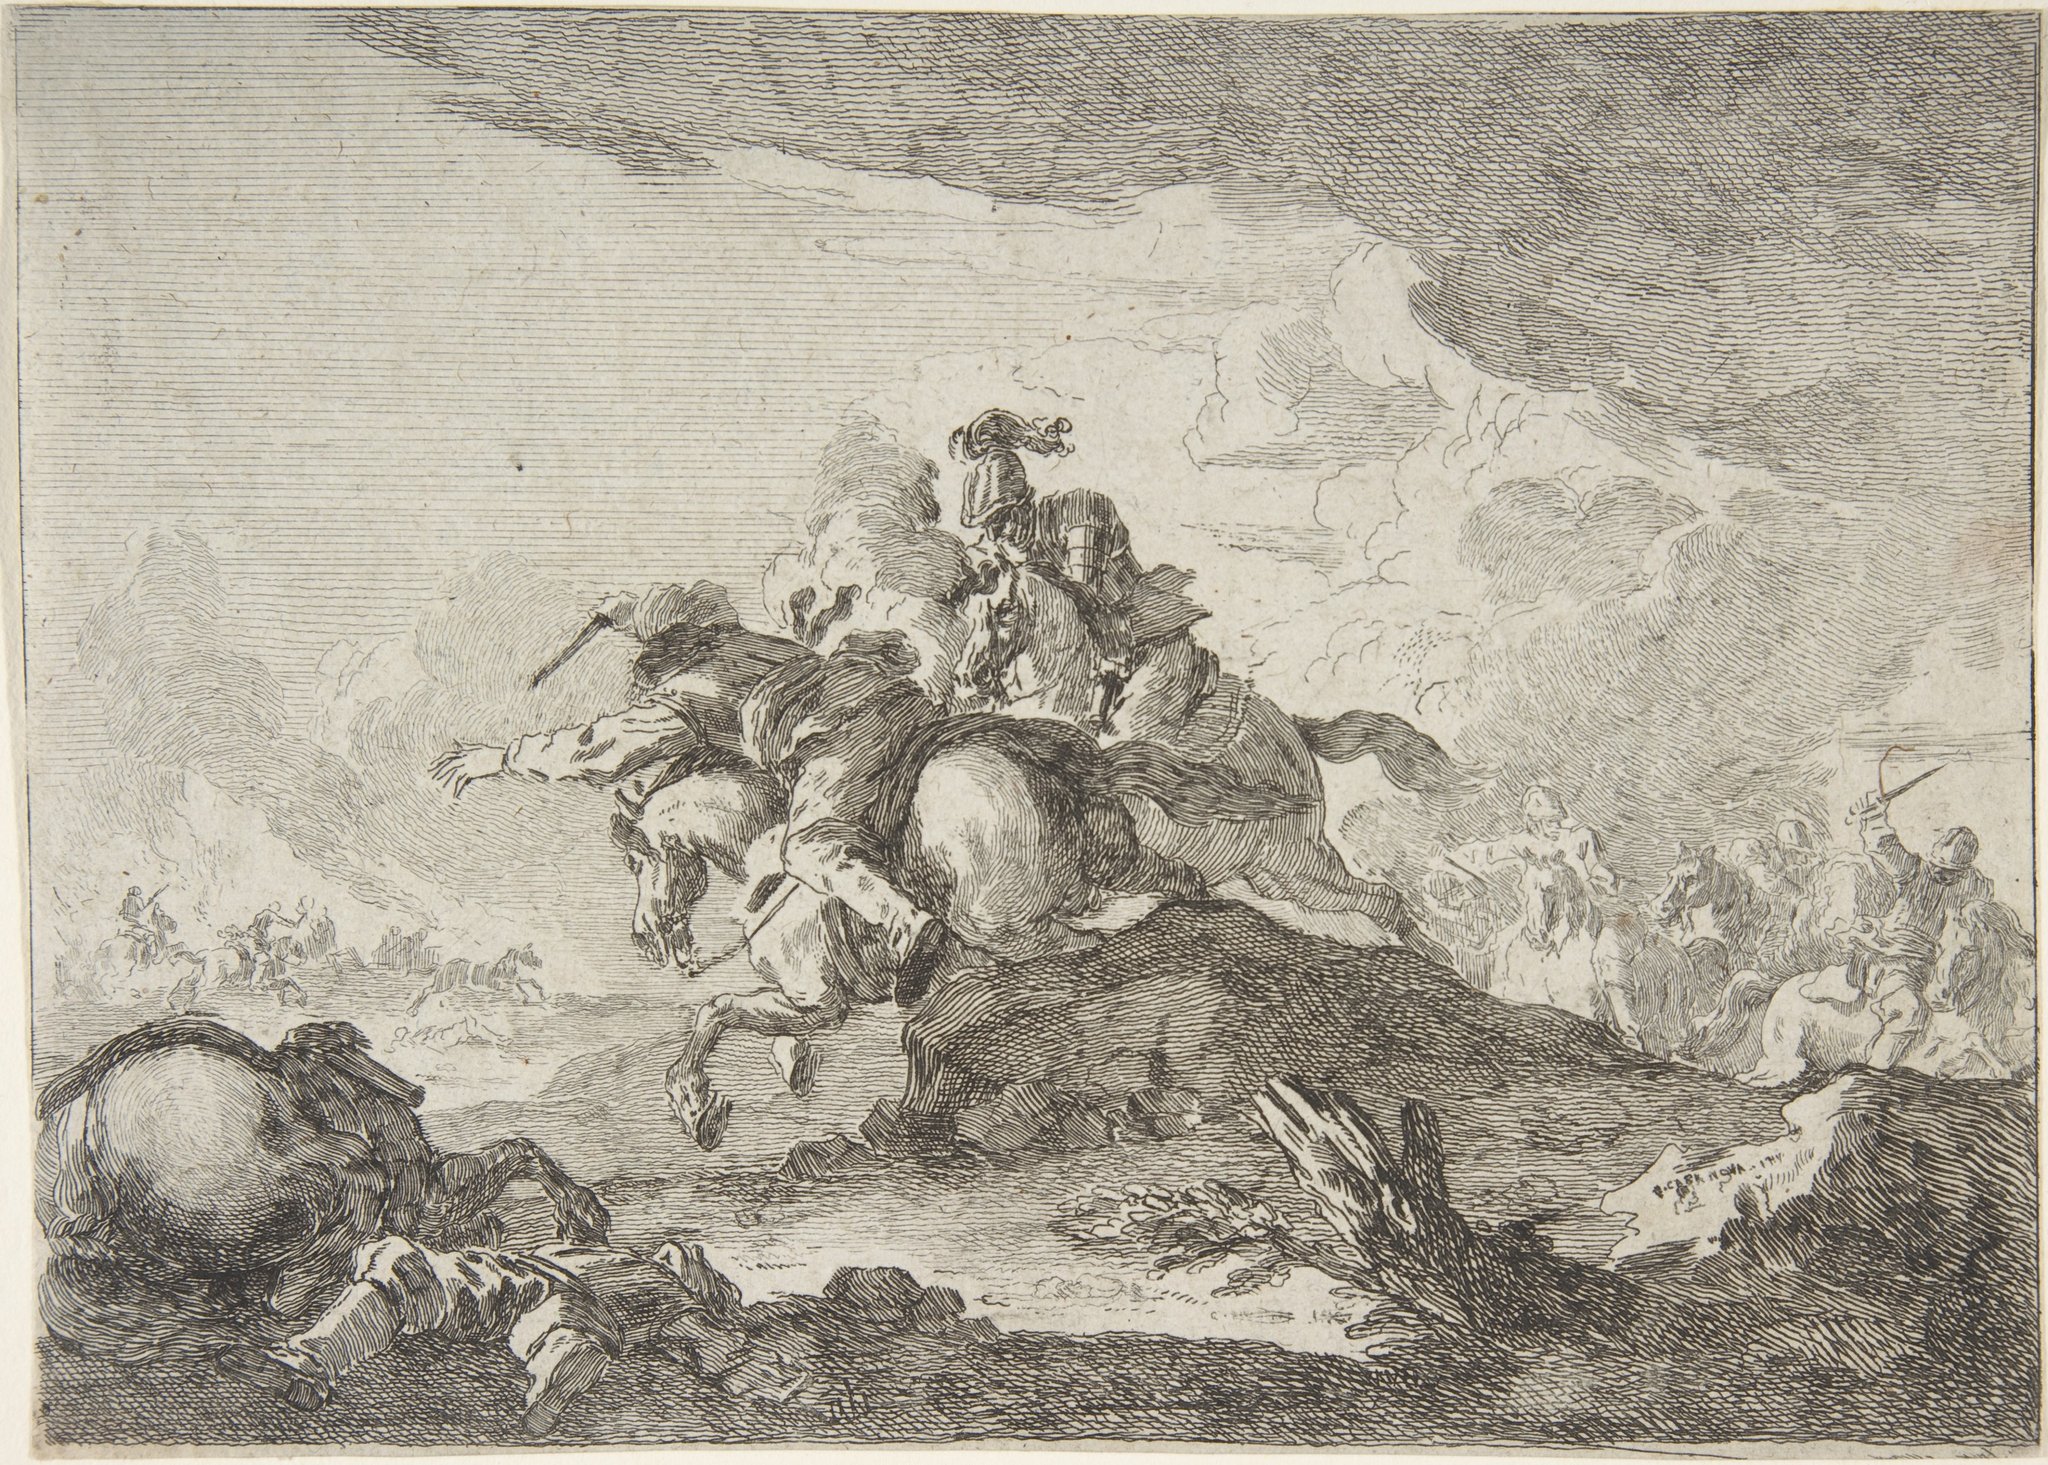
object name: print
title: Cavalry Charge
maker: francesco casanova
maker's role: artist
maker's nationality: italian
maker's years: 1727-1803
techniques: etching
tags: soldiers,horses